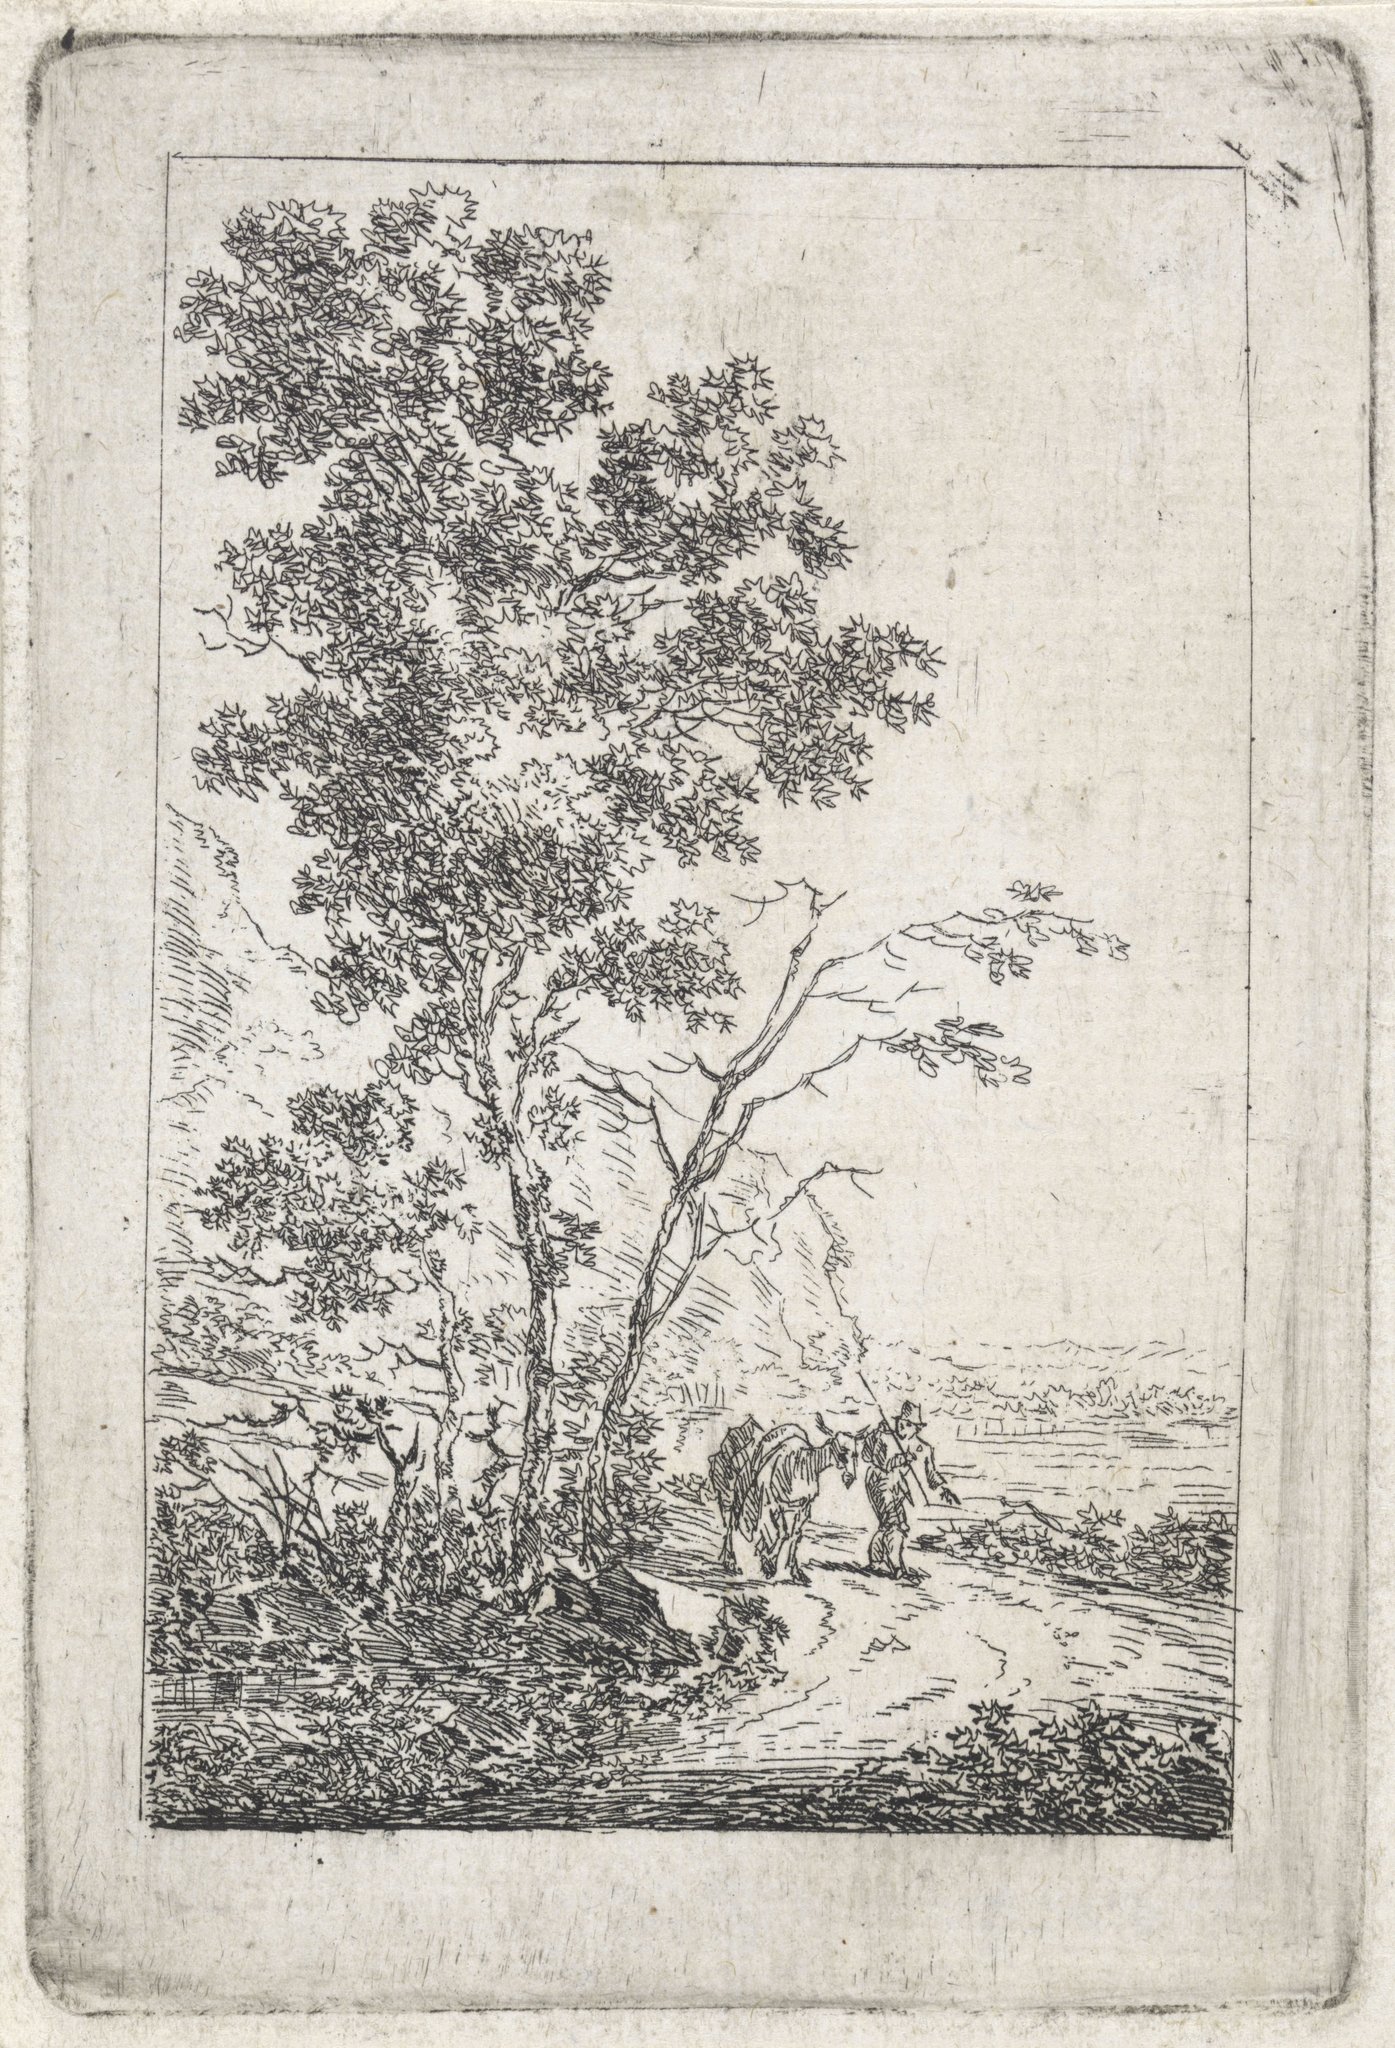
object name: print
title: Man met ezel in een landschap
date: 1766-1815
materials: paper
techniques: etching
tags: trees, ass, donkey, landscapes in the temperate zone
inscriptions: collector's mark: Lugt 2228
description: Man met ezel op een landweg. Links bomen.